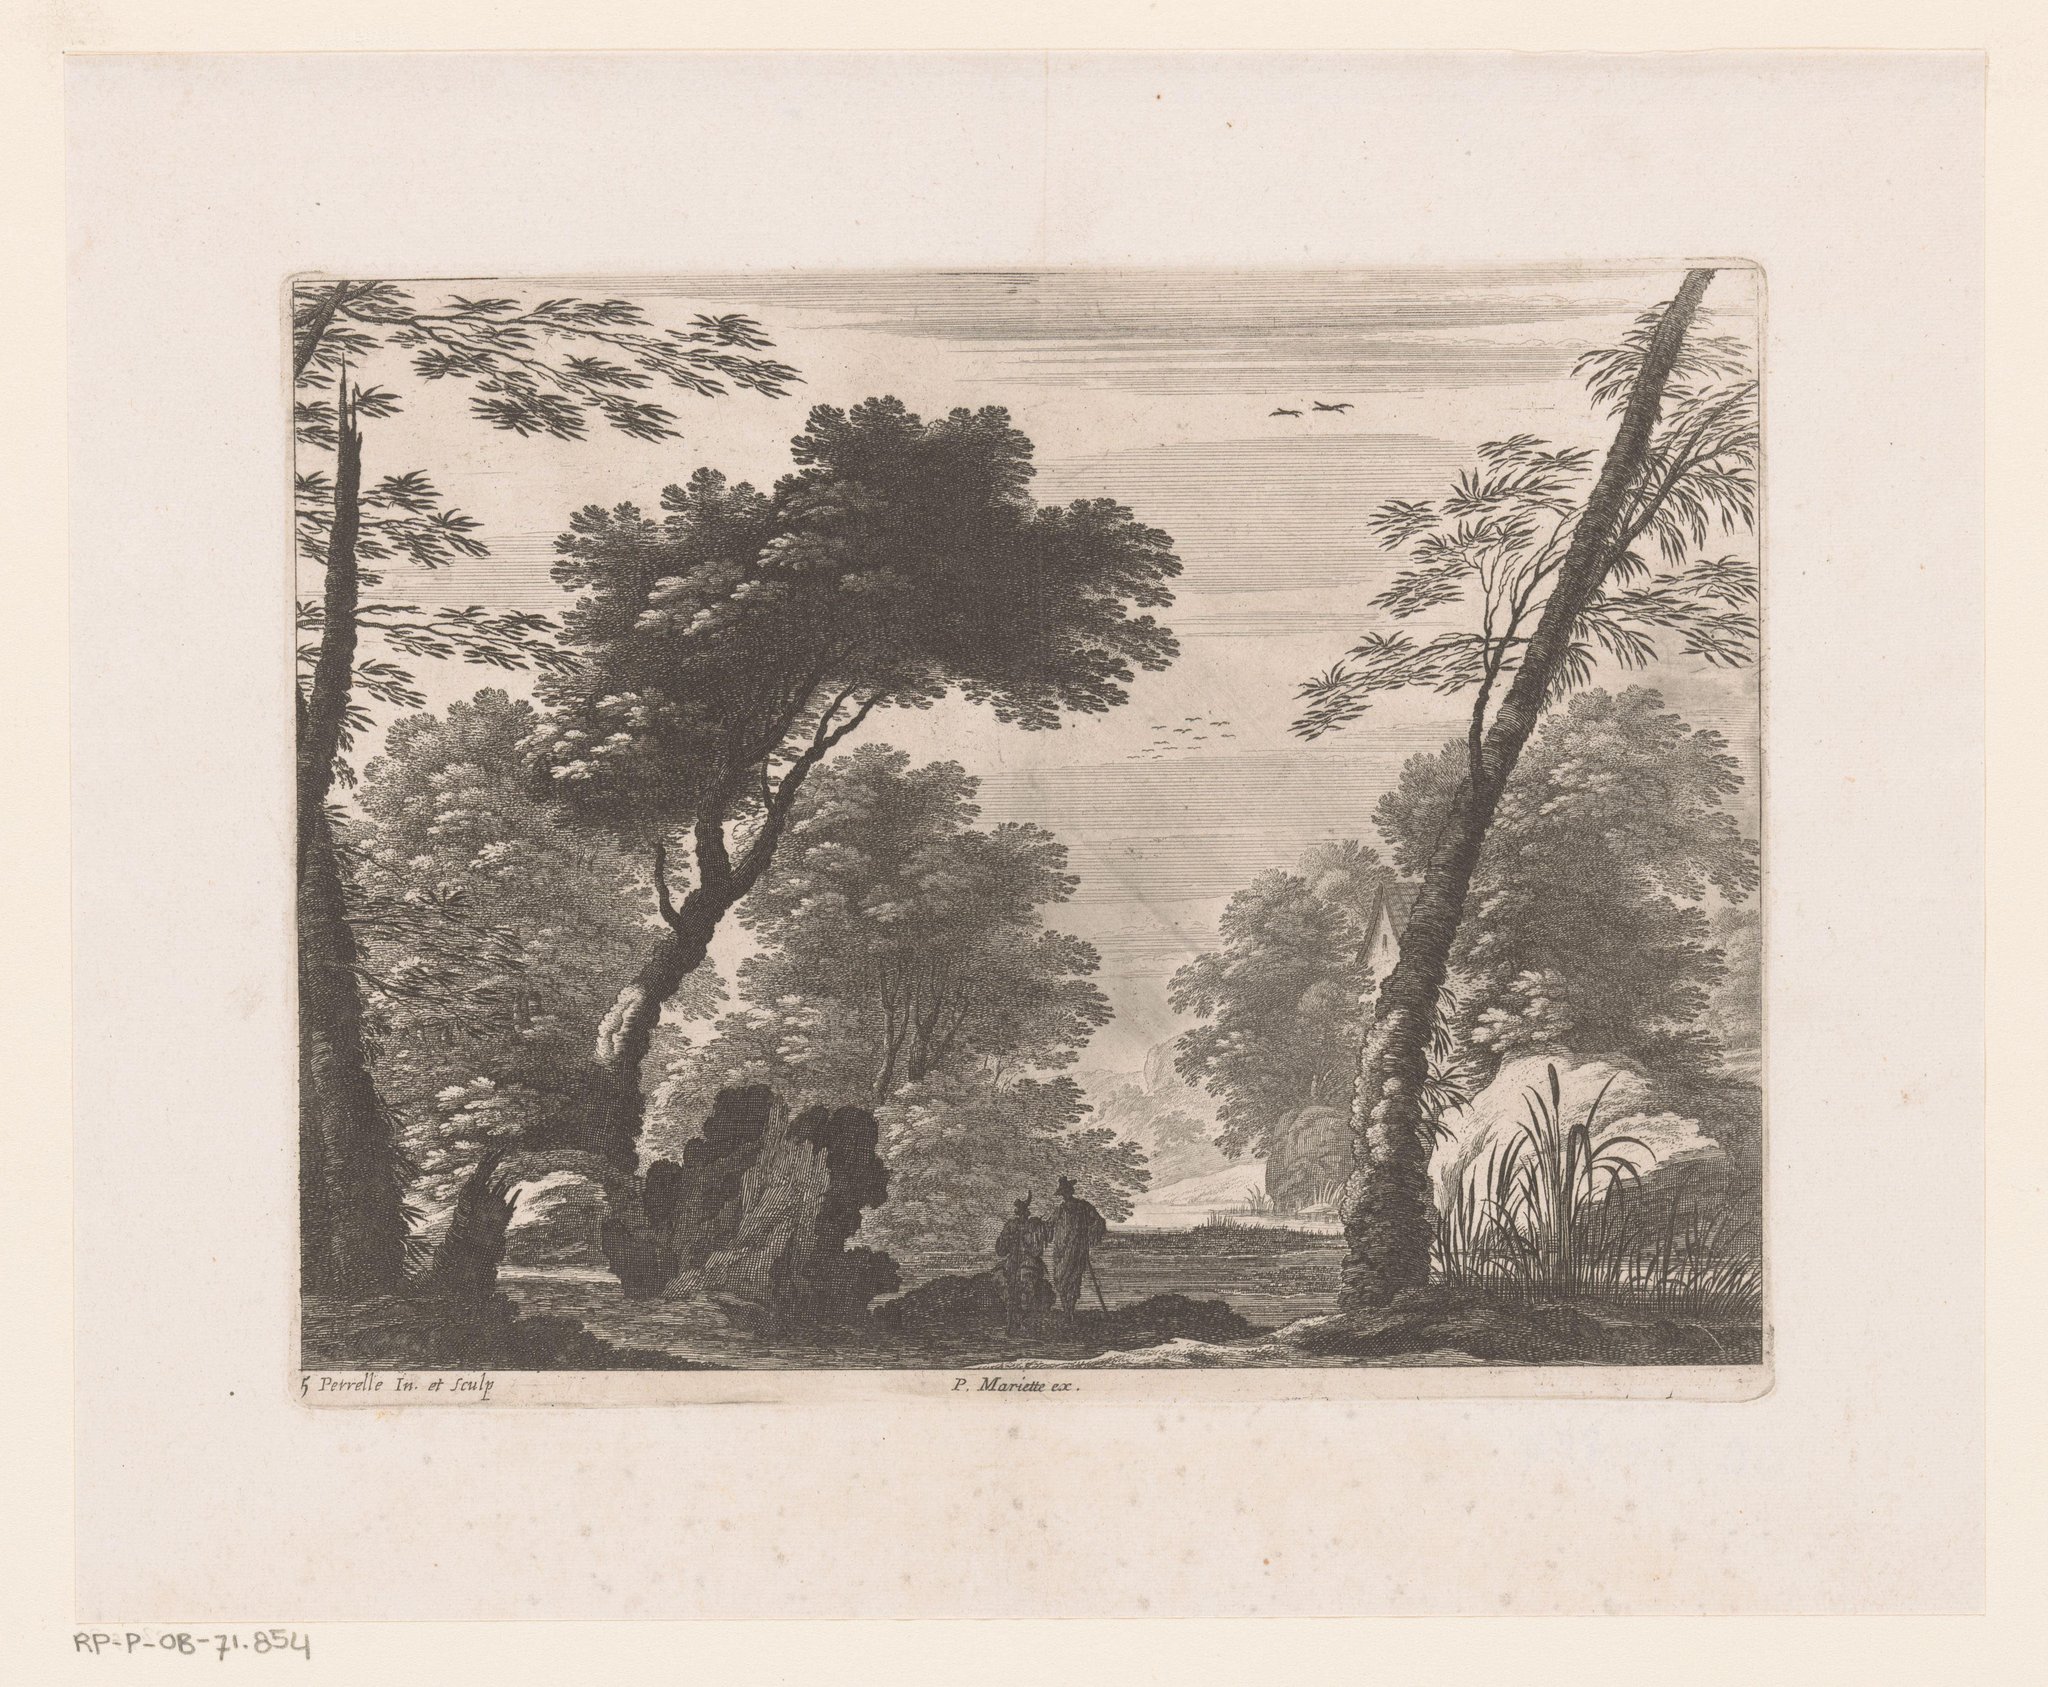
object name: print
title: Boslandschap met twee mannen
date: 1613-1695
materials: paper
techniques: engraving, etching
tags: forest, wood (+ landscape with figures, staffage)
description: Prenten met het signatuur 'Perelle' kunnen zowel door vader Gabriel als door zonen Nicolas en Adam gemaakt zijn.